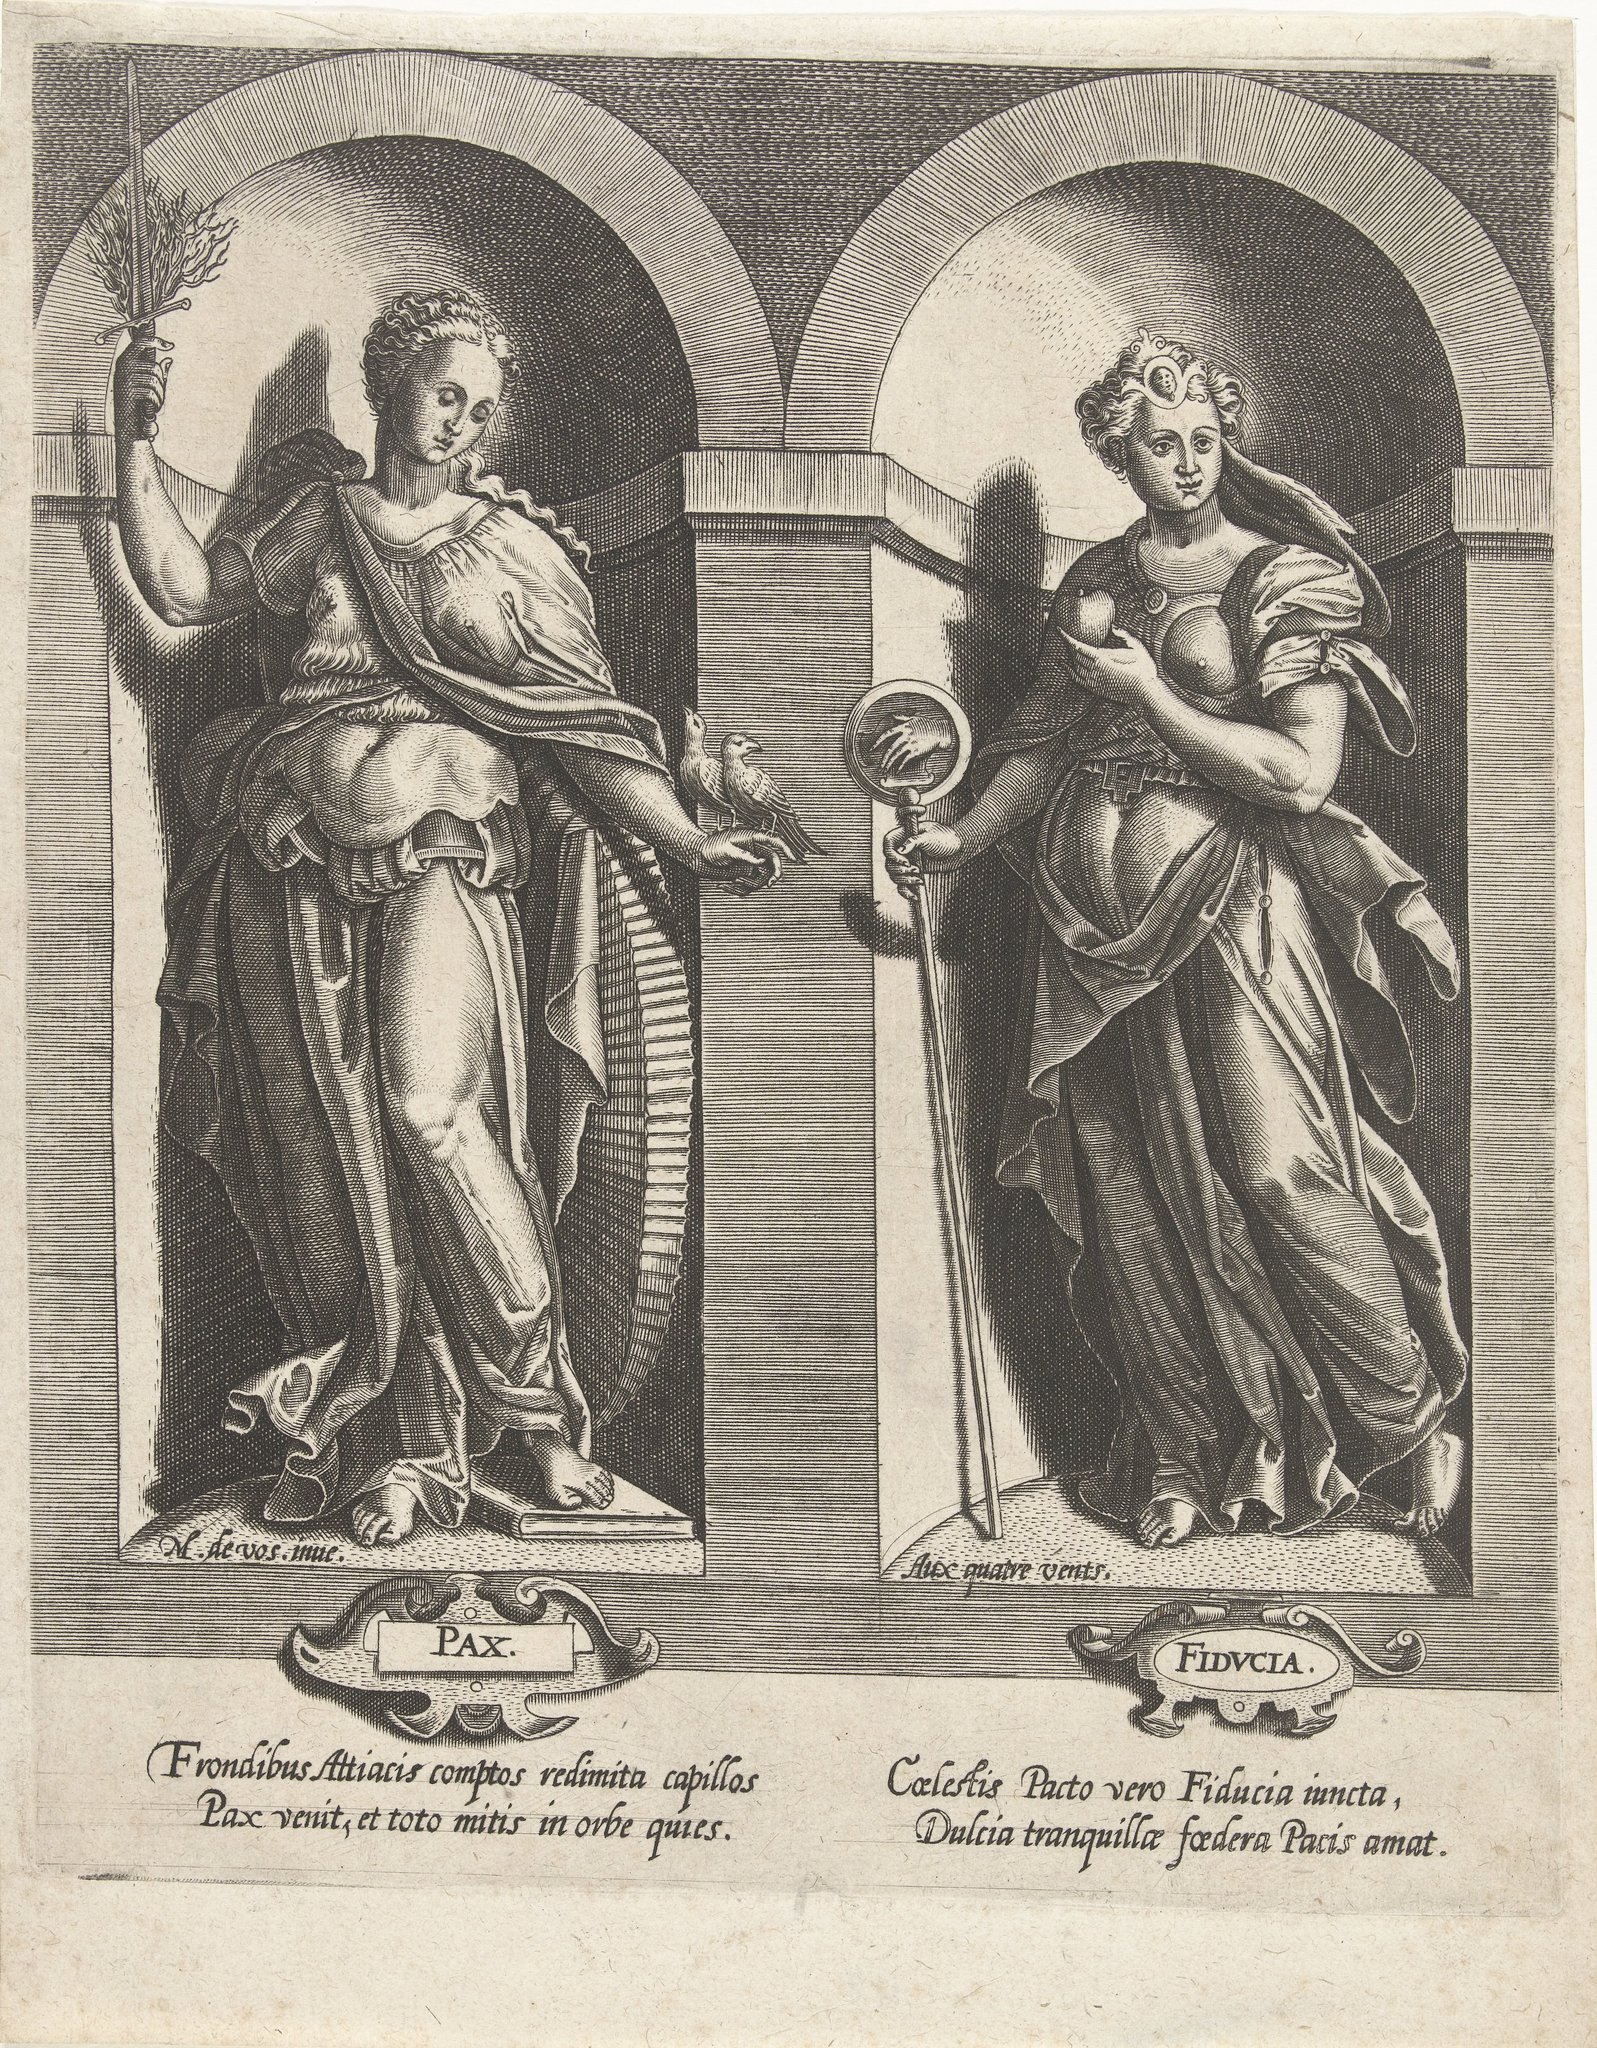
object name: print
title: Pax - Fidvcia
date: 1577-1580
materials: paper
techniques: engraving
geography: antwerp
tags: symbols, allegories of peace, 'pax'; 'pace' (ripa), trust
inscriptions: collector's mark: Lugt 2760, collector's mark: Lugt 2228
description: Links in een nis de vrouwelijke personificatie van Vrede (Pax). Op haar linkerhand zitten enkele duiven. In haar rechterhand een zwaard en een roede (oorlog en tirannie) die ze verwijdert van de aarde . Rechts naast haar in een nis de vrouwelijke personificatie van Vertrouwen (Fiducia). In haar handen een hart (liefde) en een staf met een uitgestoken hand (vriendschap). De prent heeft een Latijns onderschrift en maakt deel uit van een serie die verschillende deugdzame allegorieën verbindt met elkaar.